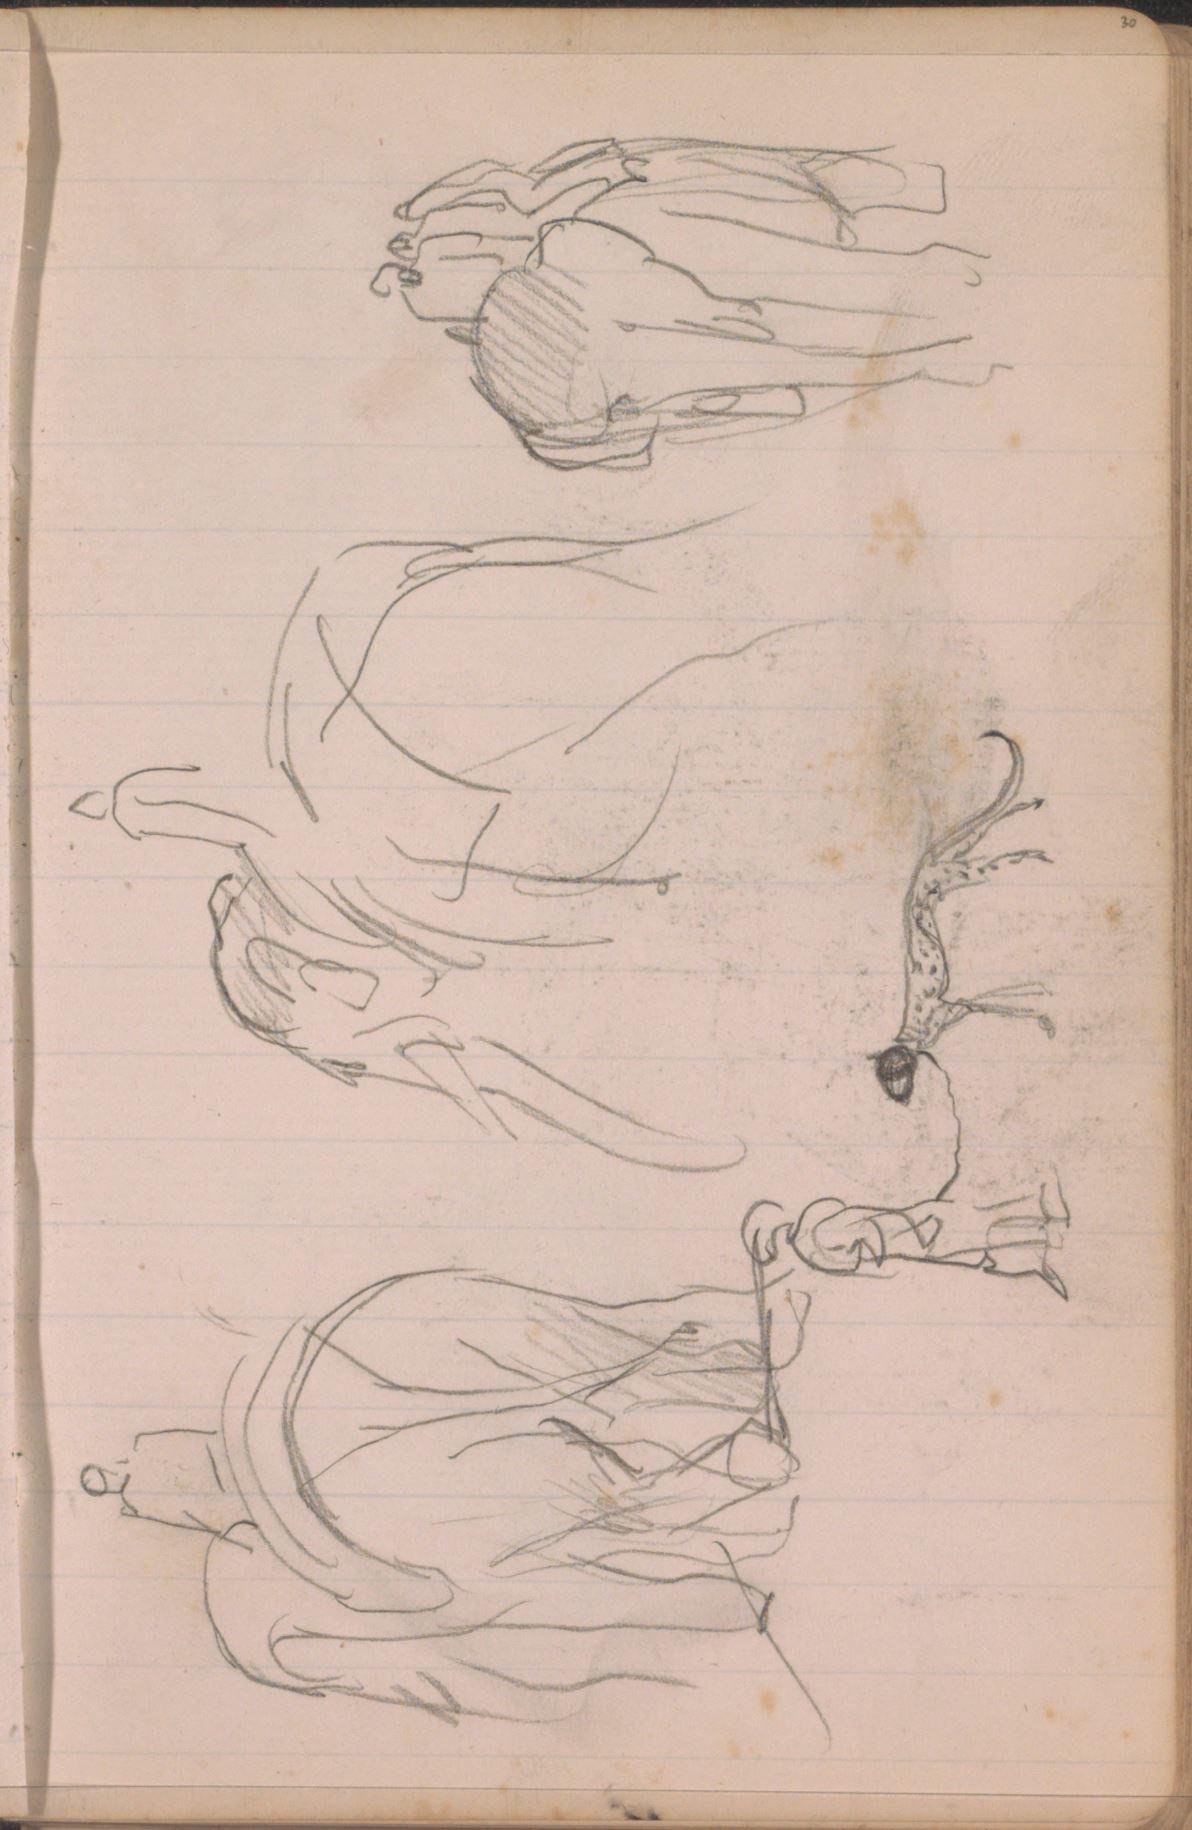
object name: sketchbook leaf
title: Figuren op olifanten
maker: marius bauer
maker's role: draughtsman, print maker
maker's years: 1867-1932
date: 1897-1898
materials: pencil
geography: india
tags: beasts of prey, predatory animals: leopard, sitting figure, asiatic races and peoples: indians, trunked animals: elephant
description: Tevens een studie van een figuur met een luipaard aan een ketting. Pagina 30 uit een schetsboek met 84 bladen.